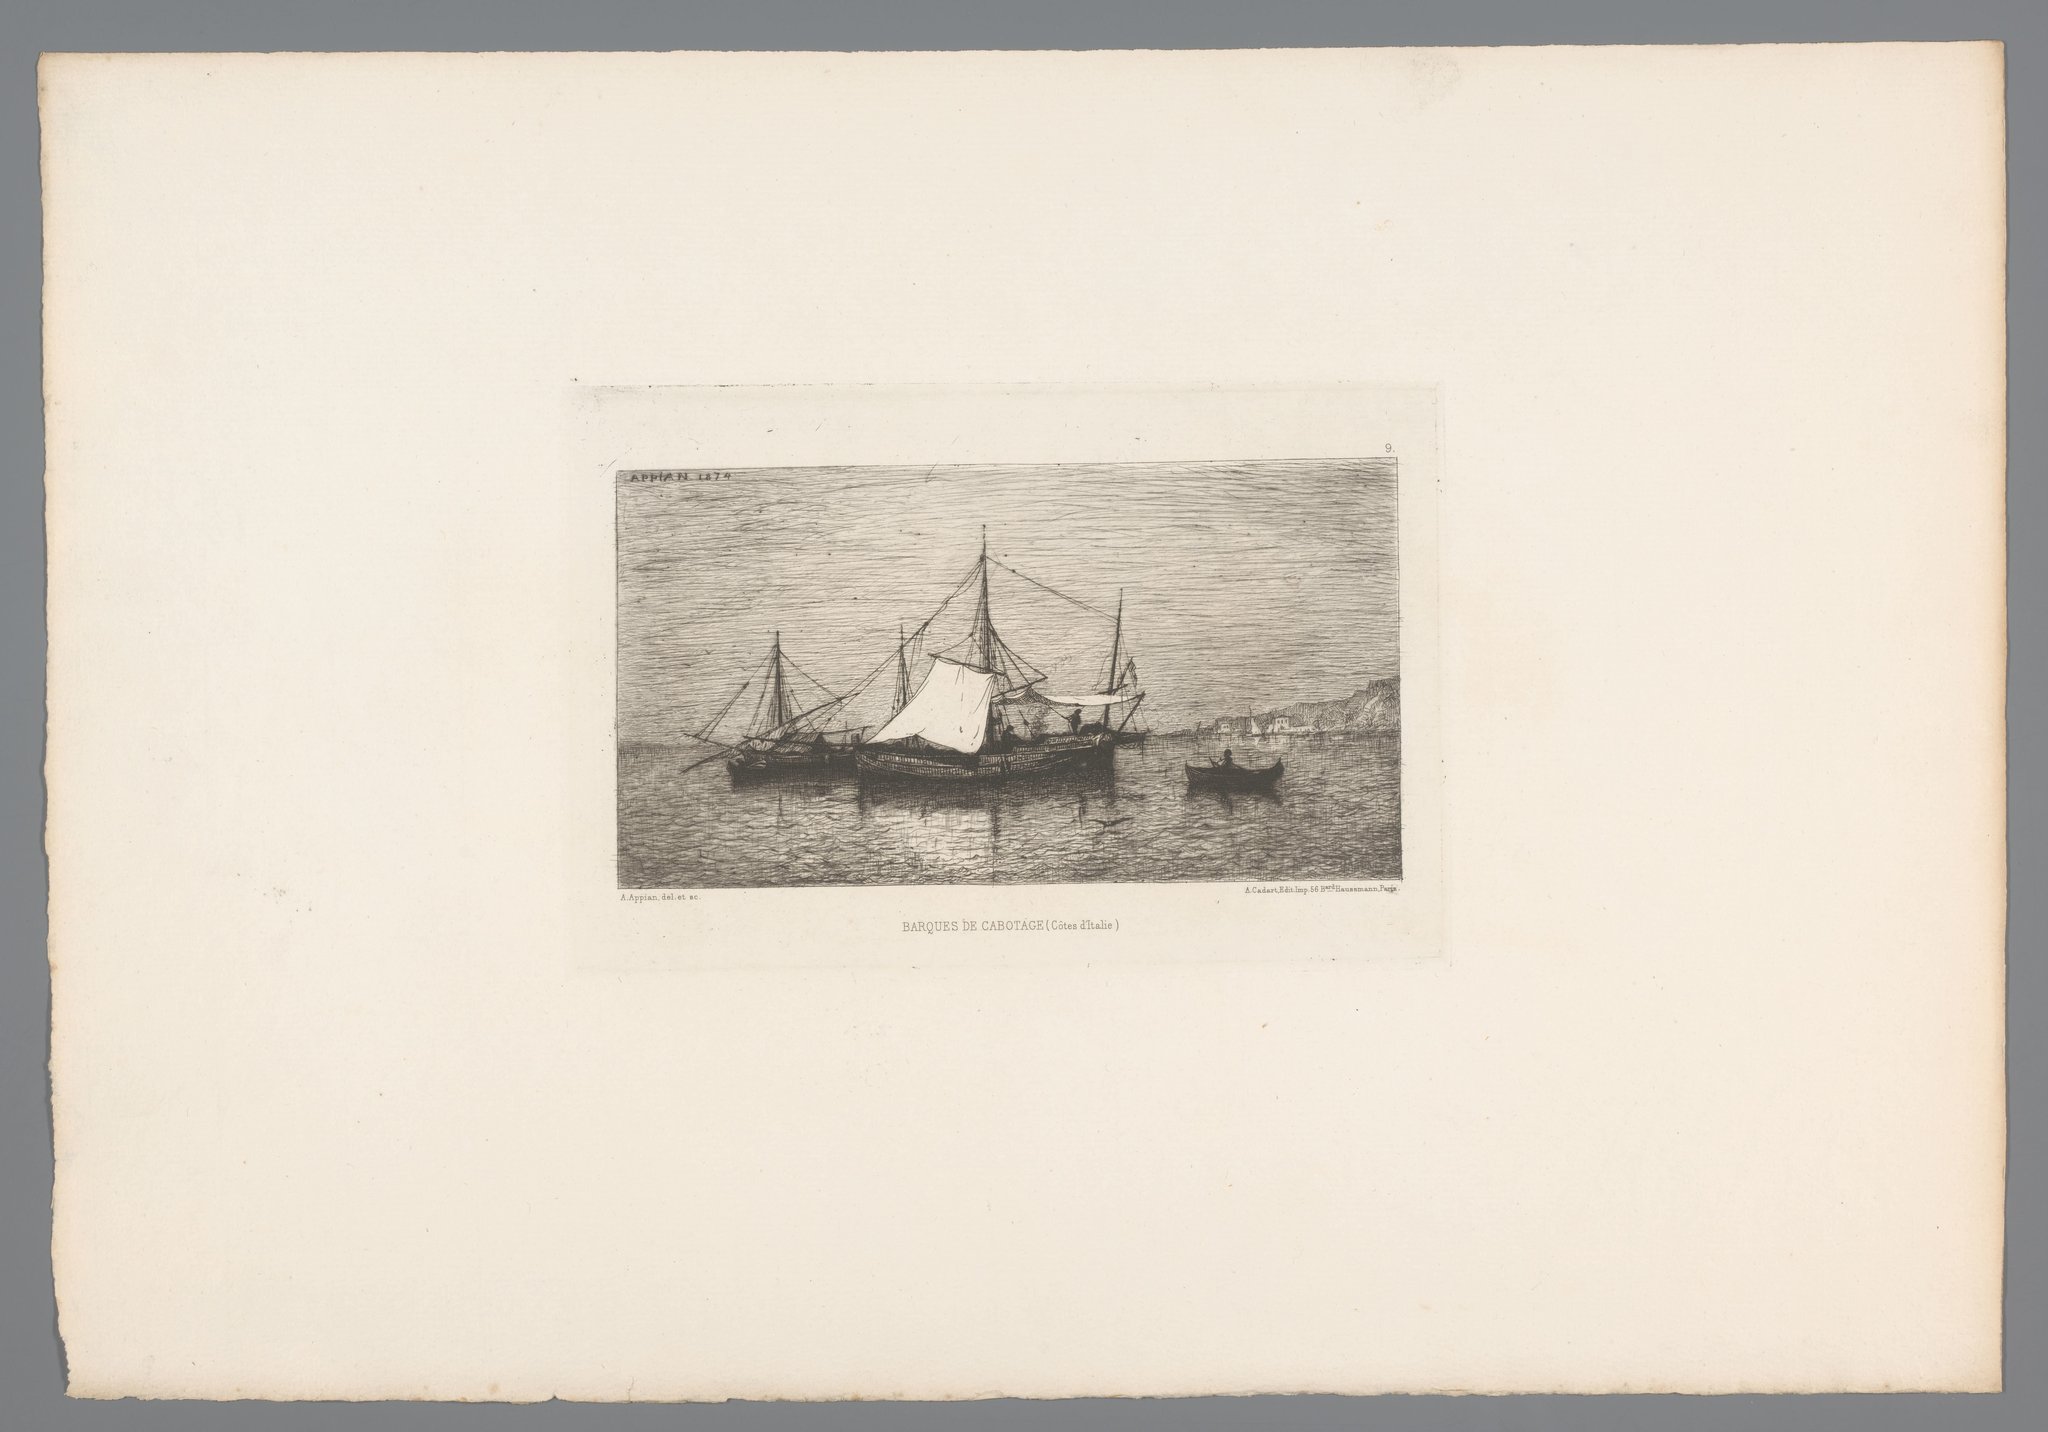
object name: print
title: Barques de cabotage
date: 1875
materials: paper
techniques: drypoint, etching, intaglio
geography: paris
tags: ships (in general) - cc - more than one ship, sea, italy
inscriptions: watermark, collector's mark: Lugt 2228, collector's mark: ‘AFE v S’, collector's mark: Lugt 2760